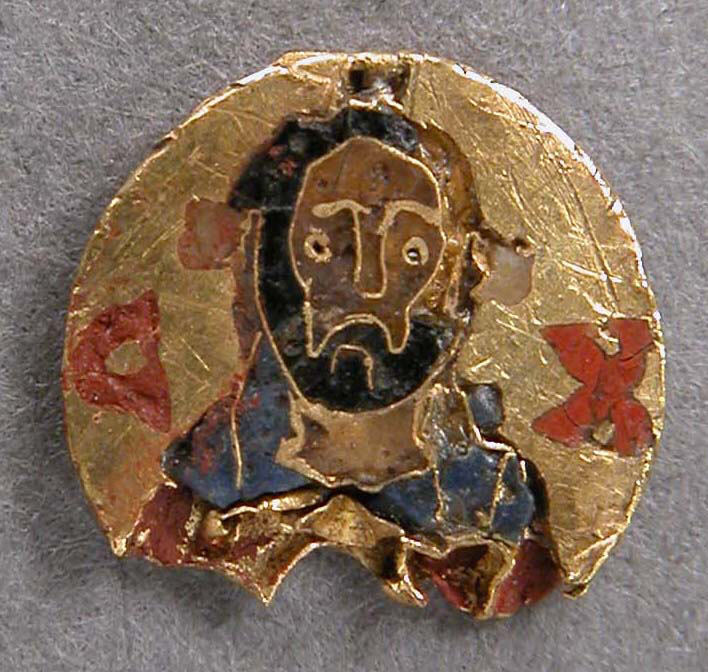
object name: medallion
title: Medallion with Christ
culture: byzantine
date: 1001-1100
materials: enamel, gold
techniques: enamel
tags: christ